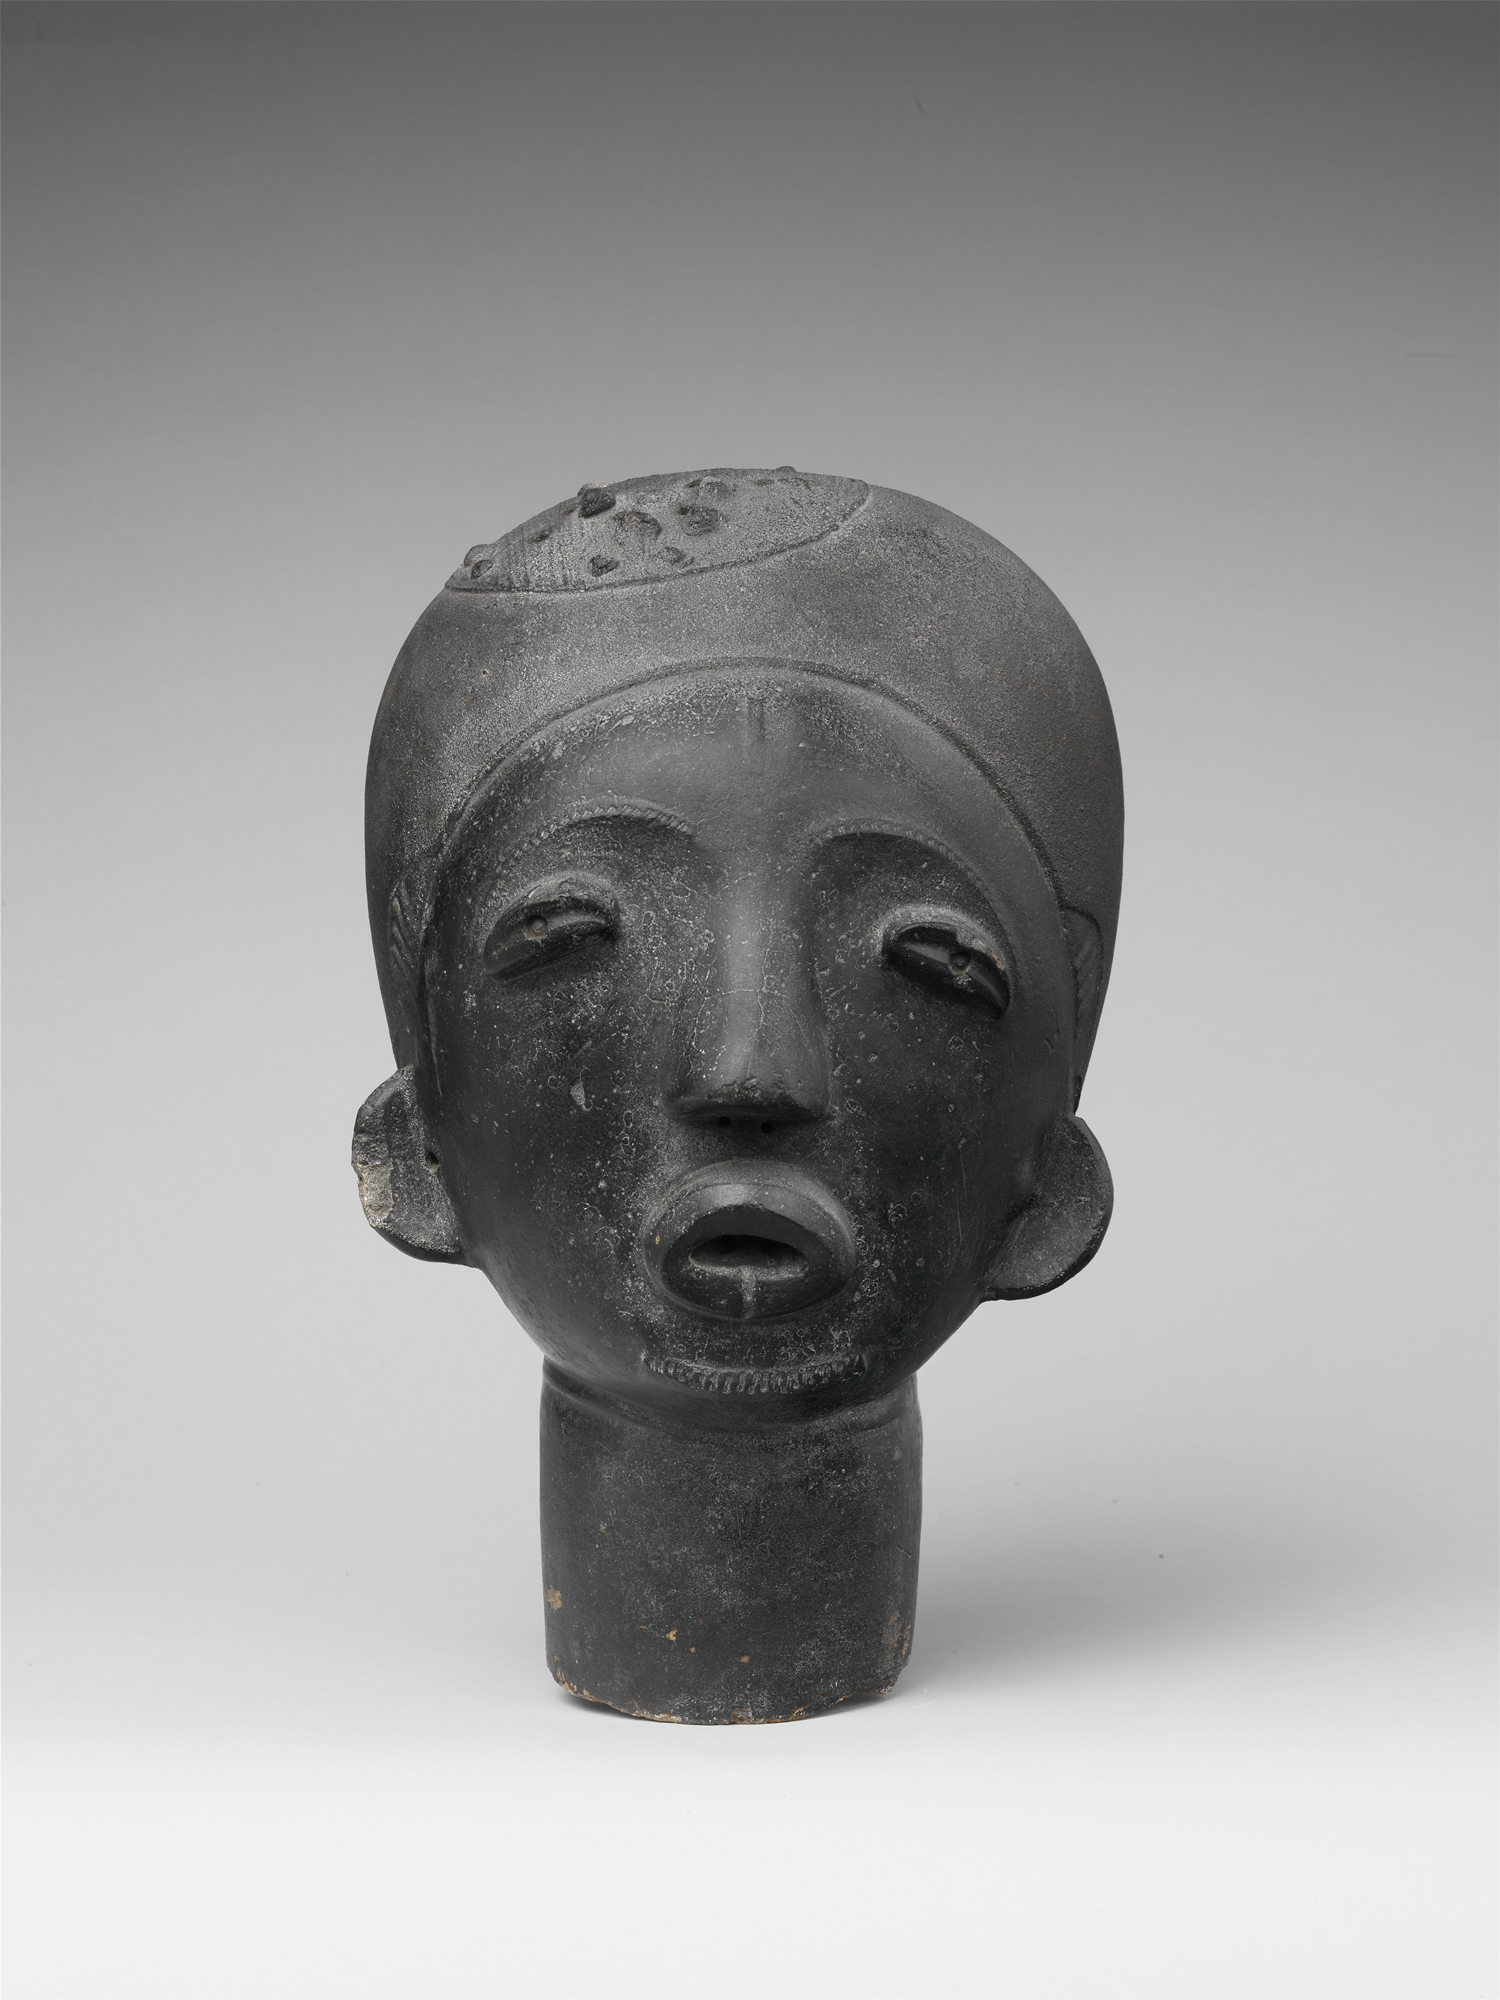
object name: head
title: Male ntiri (memorial head)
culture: akan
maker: akan artist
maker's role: artist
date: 1601-1700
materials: patina, terracotta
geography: ghana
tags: heads